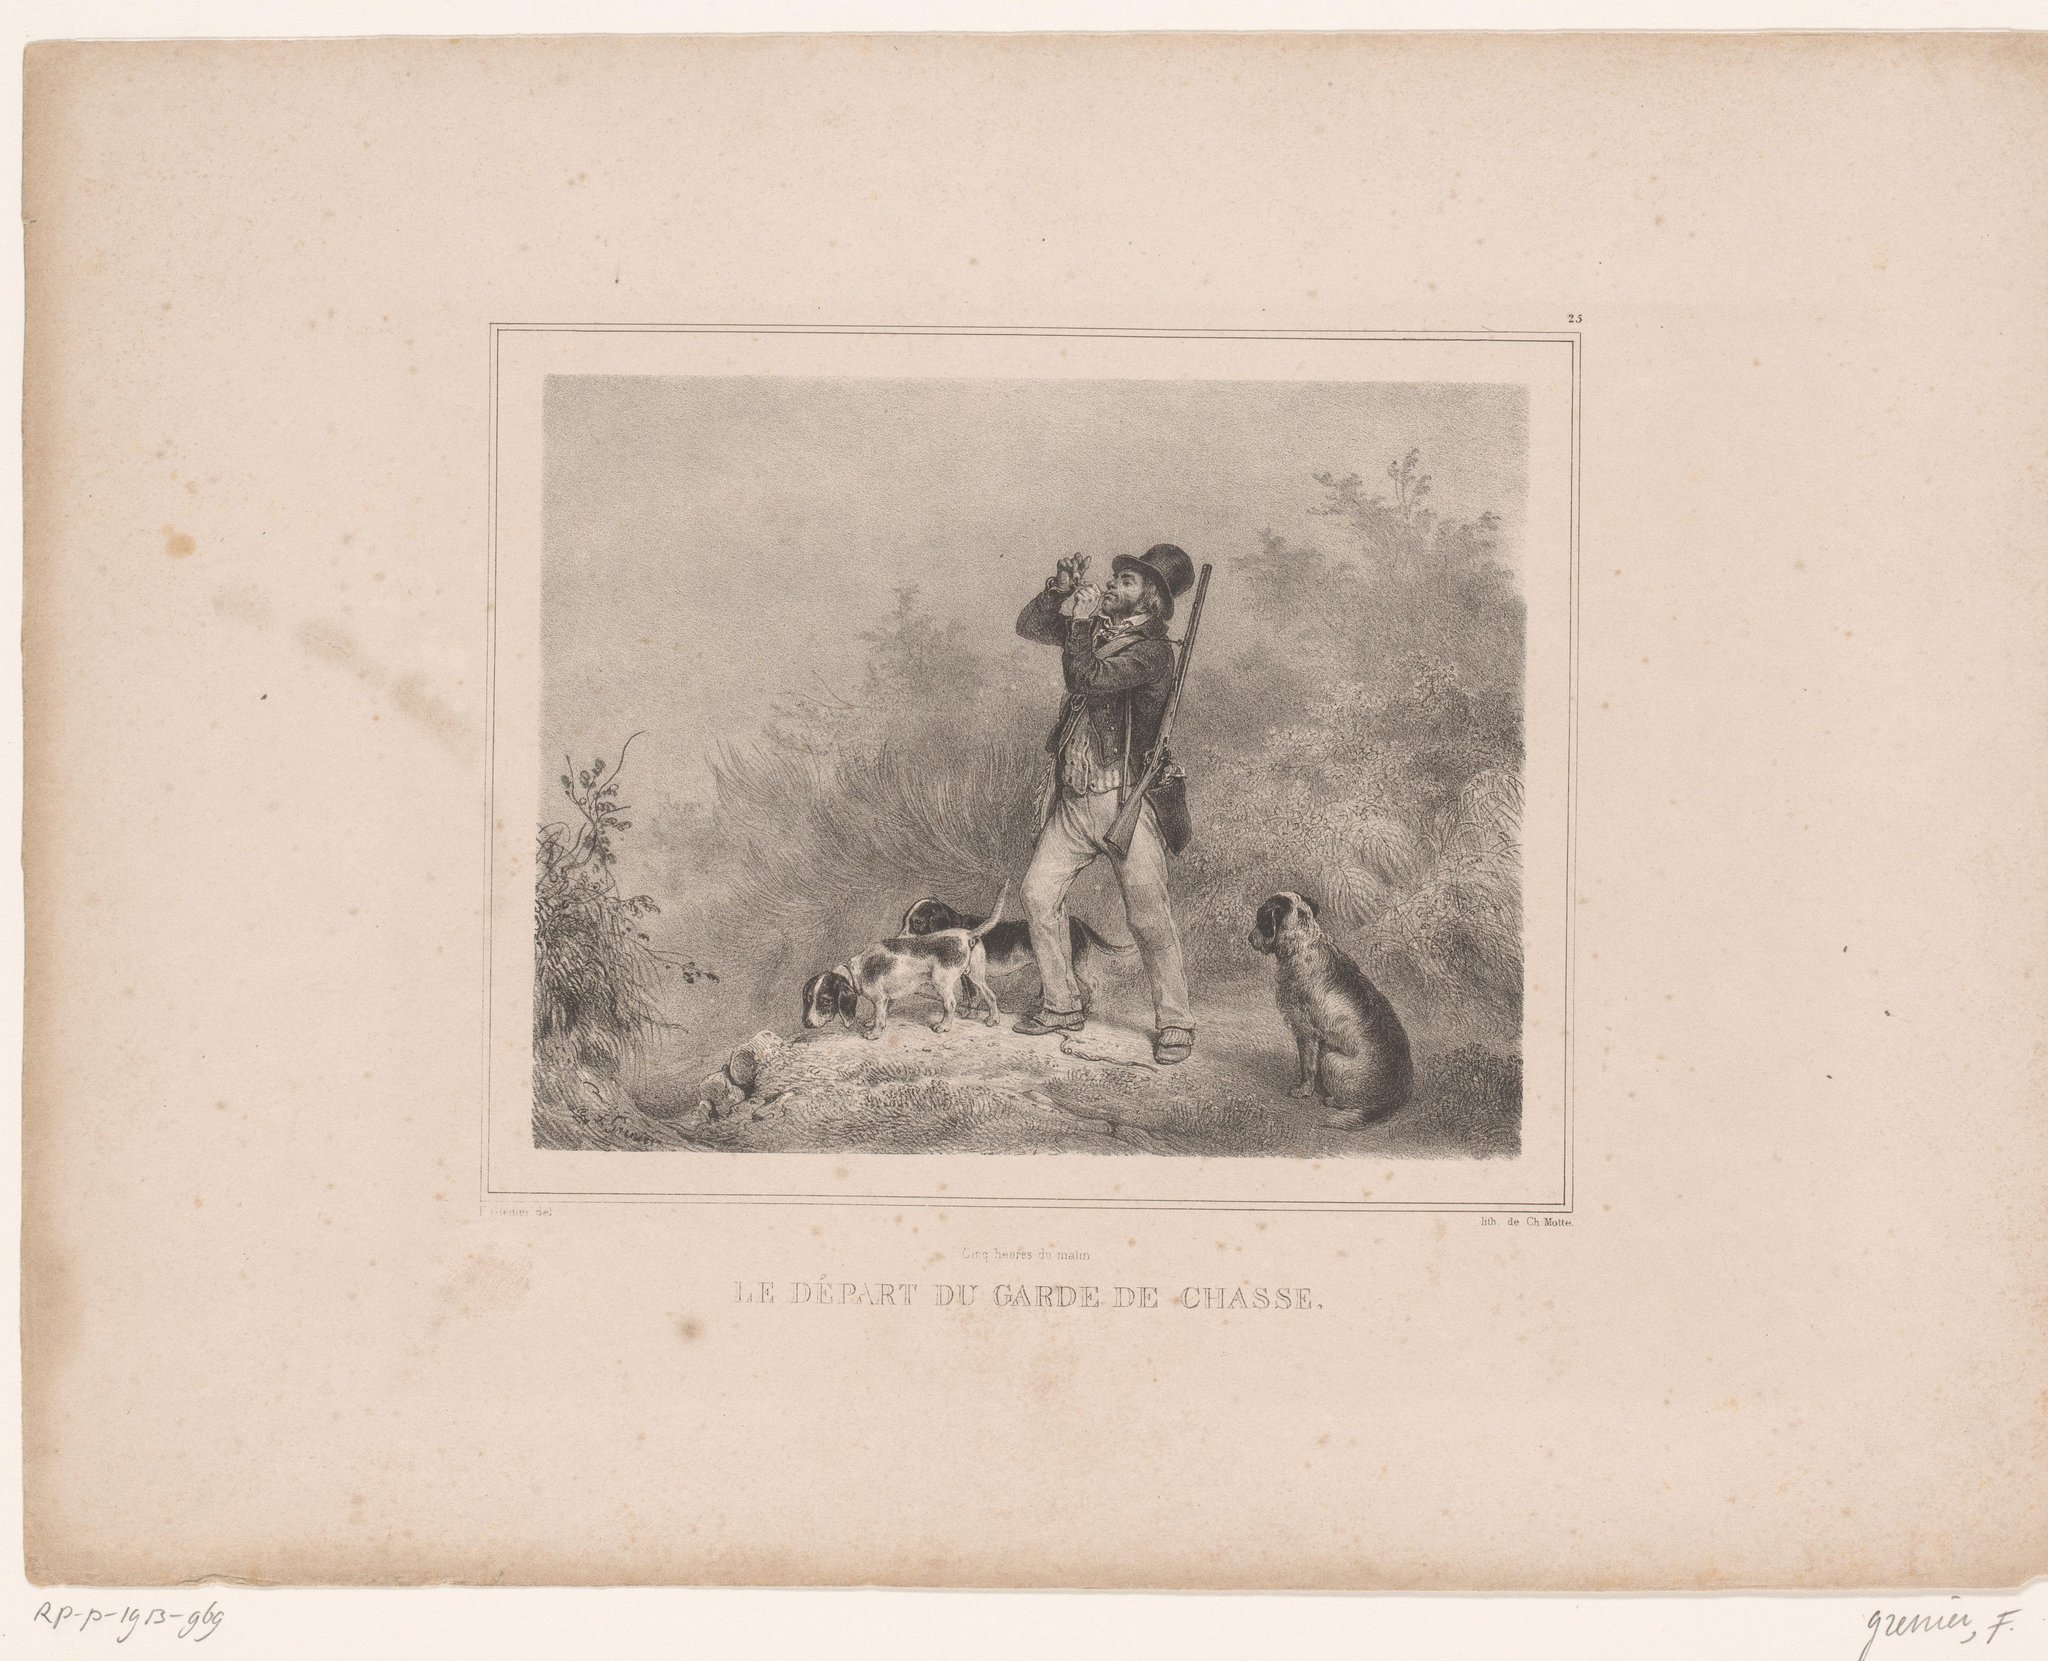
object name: print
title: Le départ du garde de chasse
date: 1819-1836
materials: paper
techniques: lithograph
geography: paris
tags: hunting dogs, gamekeeper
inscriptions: check stamp: Lugt 1828c, collector's mark: Lugt 2228a